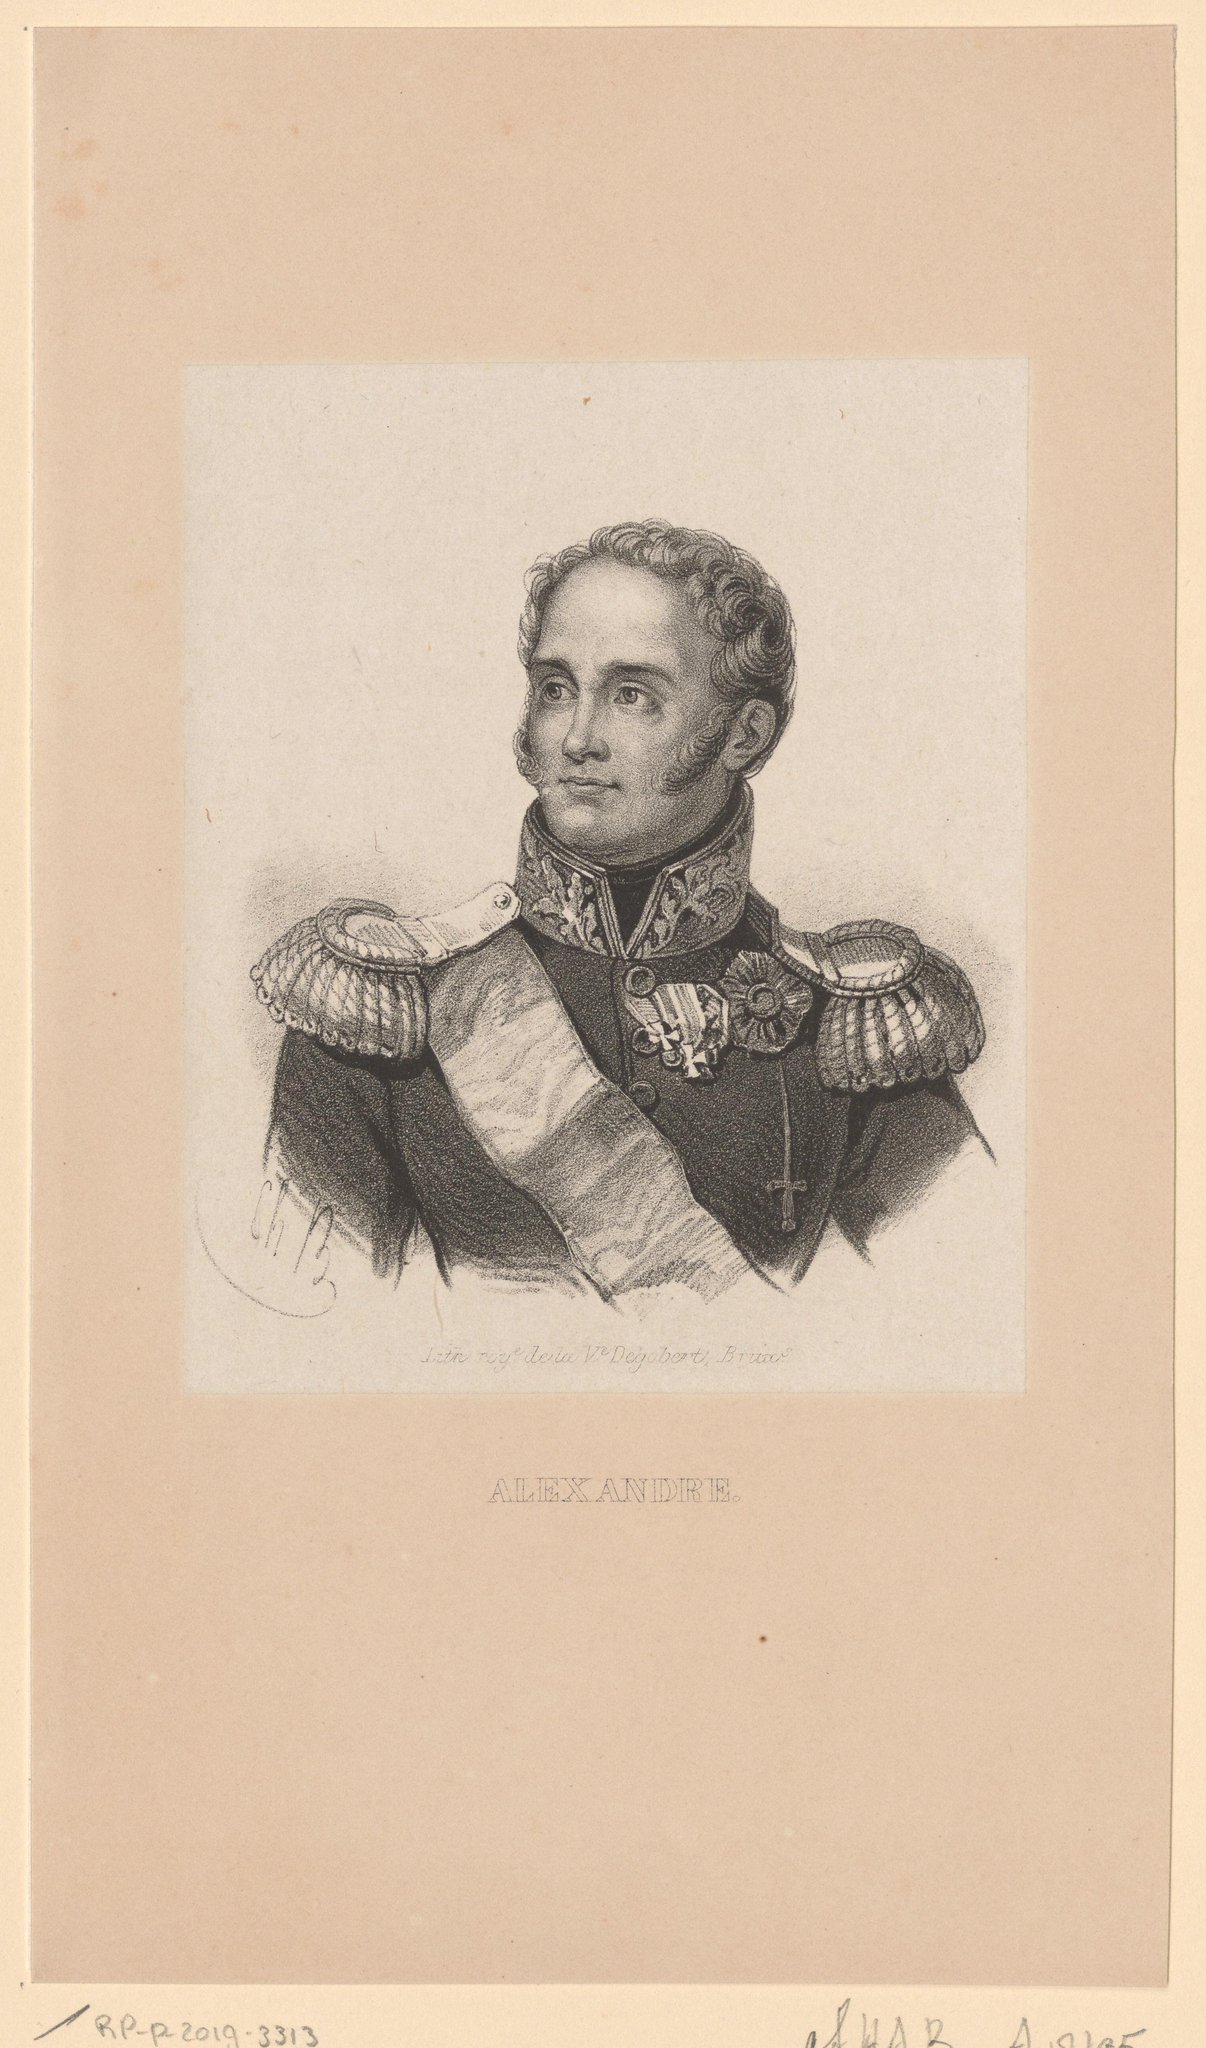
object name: print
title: Portret van Alexander I, tsaar van Rusland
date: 1844-1849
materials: paper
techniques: lithograph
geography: brussels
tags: alexander i (tsaar van rusland), historical persons, emperor